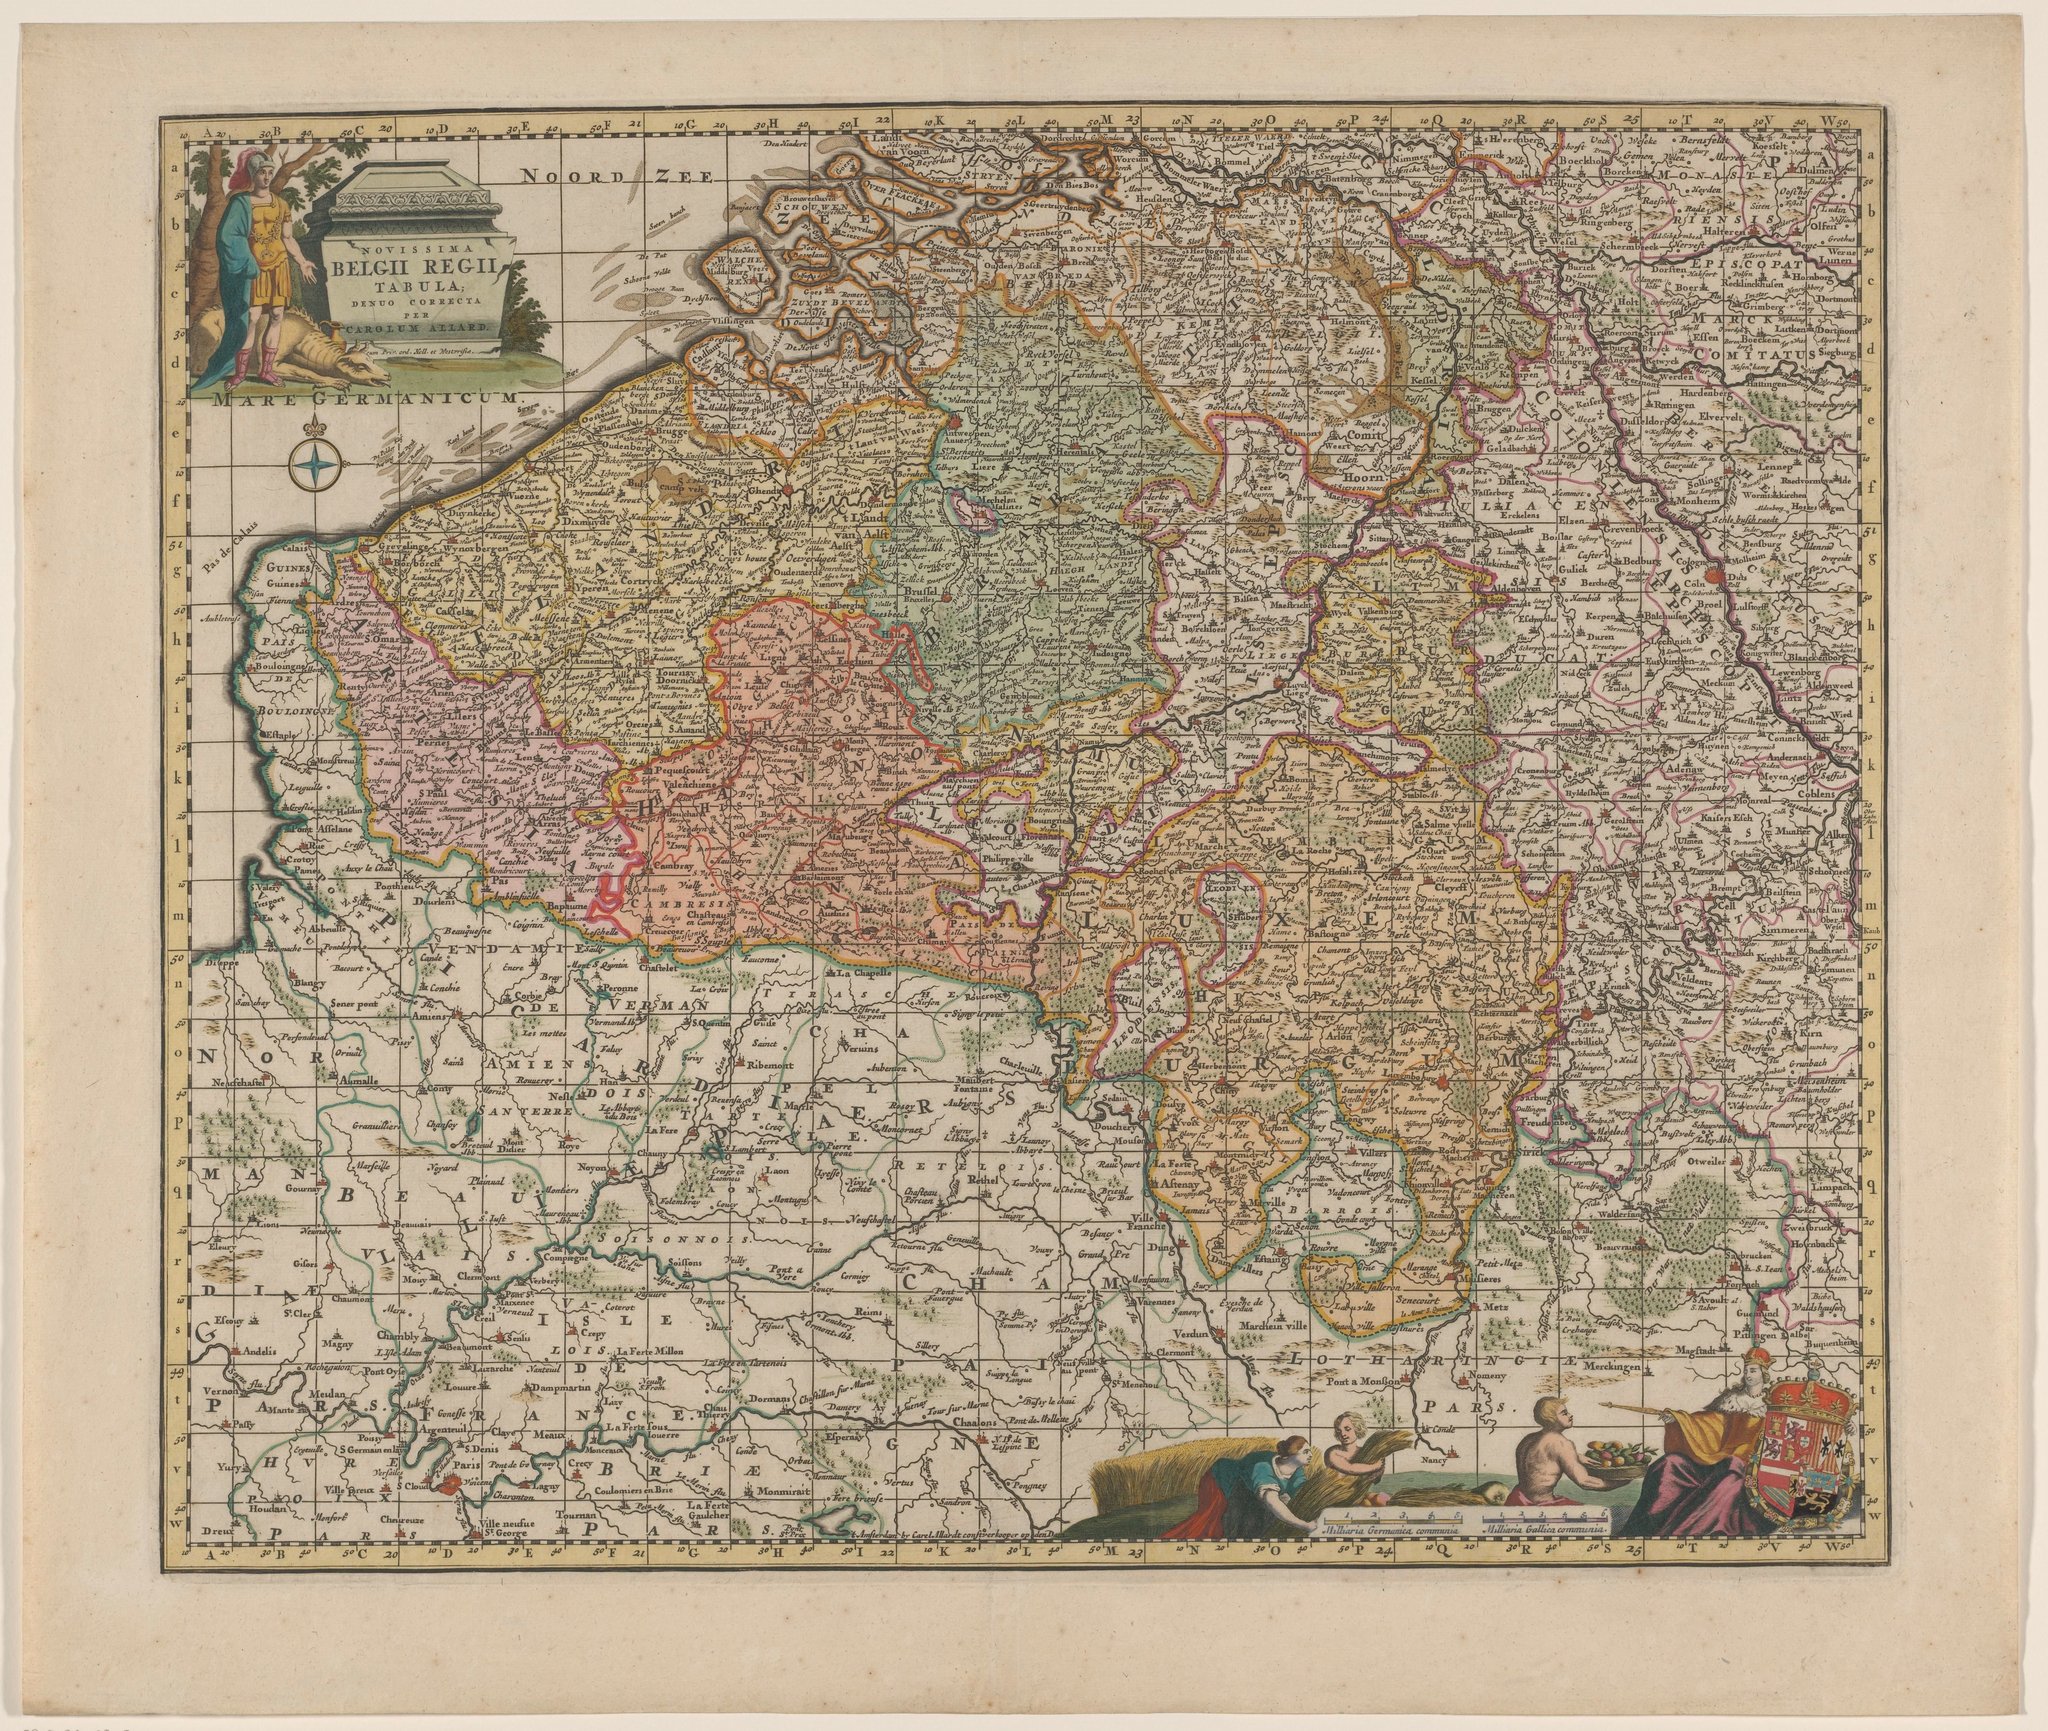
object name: map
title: Kaart van de Zuidelijke Nederlanden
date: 1683-1709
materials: paper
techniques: engraving, hand coloring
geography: amsterdam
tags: maps of separate countries or regions, dragon, armorial bearing, heraldry, southern netherlands, belgium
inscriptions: collector's mark: Lugt 2228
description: Kaart van de Zuidelijke Nederlanden. Linksboven de titelcartouche. Rechtsonder twee schaalstokken: 5 Milliaria Germanica communia / 6 Milliaria Gallica communia. Bij de schaalstokken een voorstelling met boeren die voedsel aanbieden aan een vorstin bij het wapen van de koning van Spanje. De kaart is voorzien van een zoekrooster en een gradenverdeling.